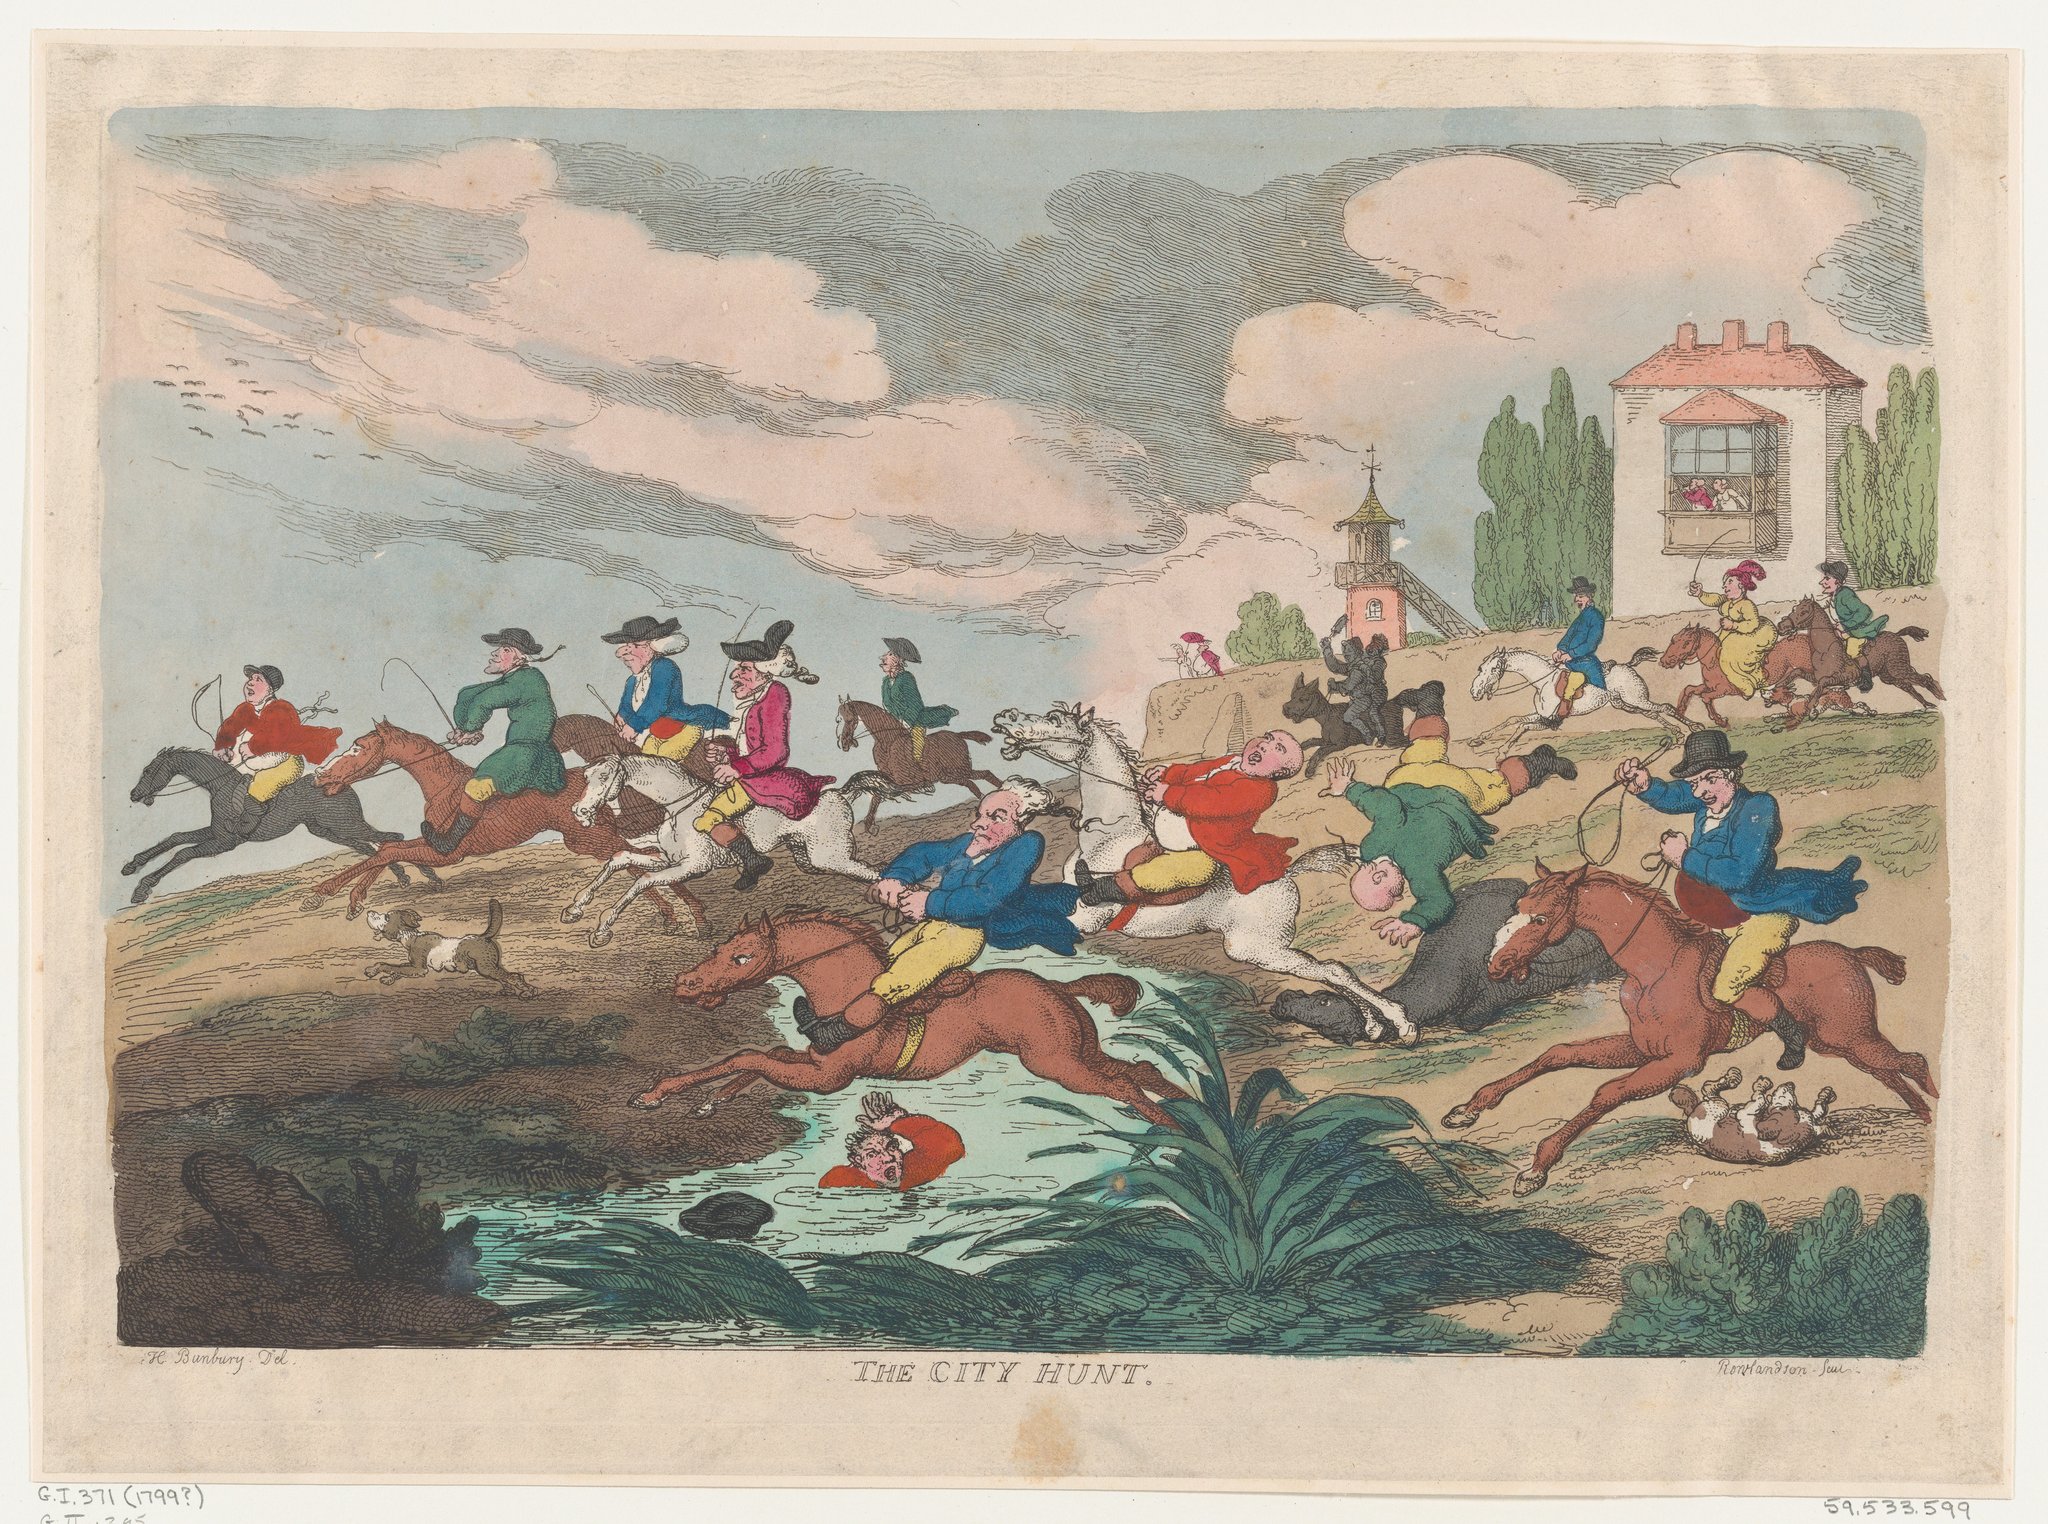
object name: print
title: The City Hunt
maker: thomas rowlandson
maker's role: artist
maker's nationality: british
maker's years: 1757-1827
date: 1810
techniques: etching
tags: satire,men,women,hunting,dogs,horses